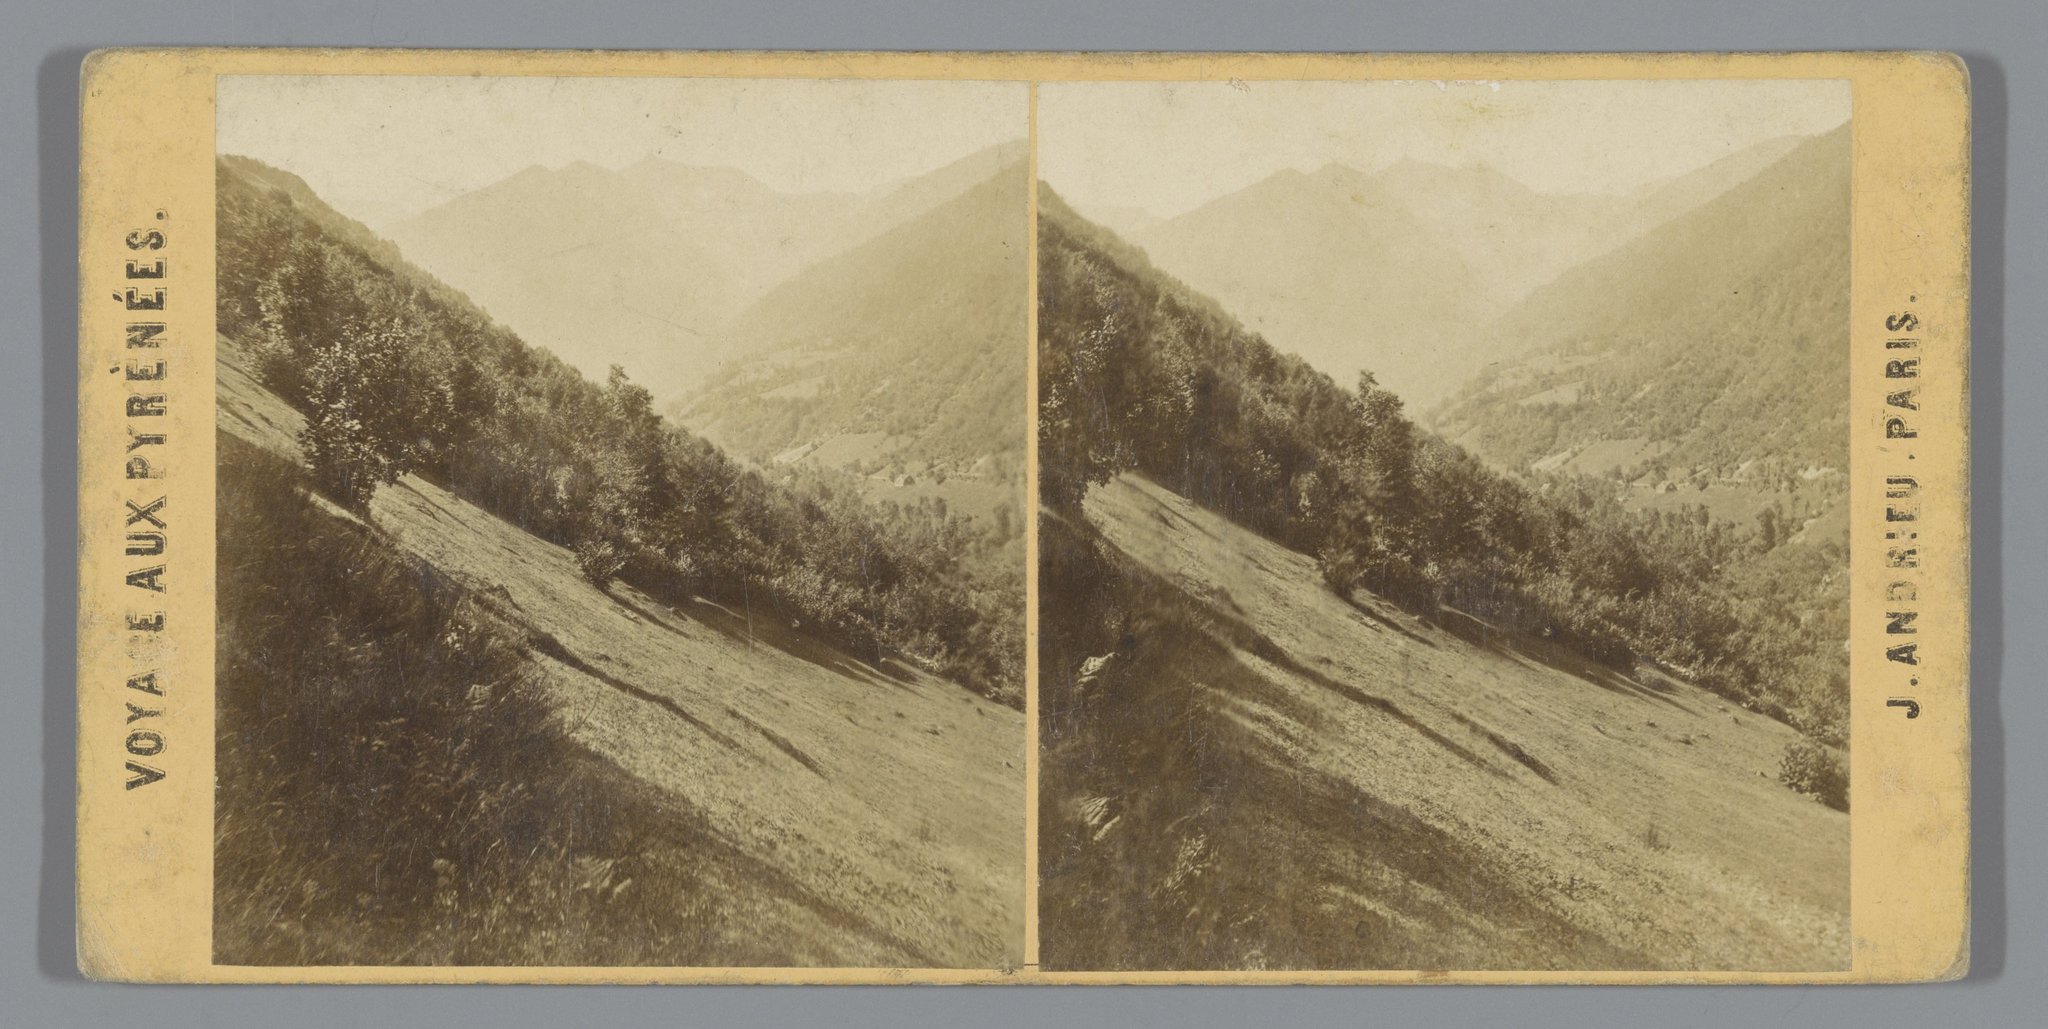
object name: stereograph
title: Vallée de Castel-Vieil a Luchon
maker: jean andrieu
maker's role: fotograaf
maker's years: 1816-1872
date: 1862-1876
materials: cardboard, photographic support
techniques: albumen print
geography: luchon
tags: dale, valley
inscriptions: number: ‘32’